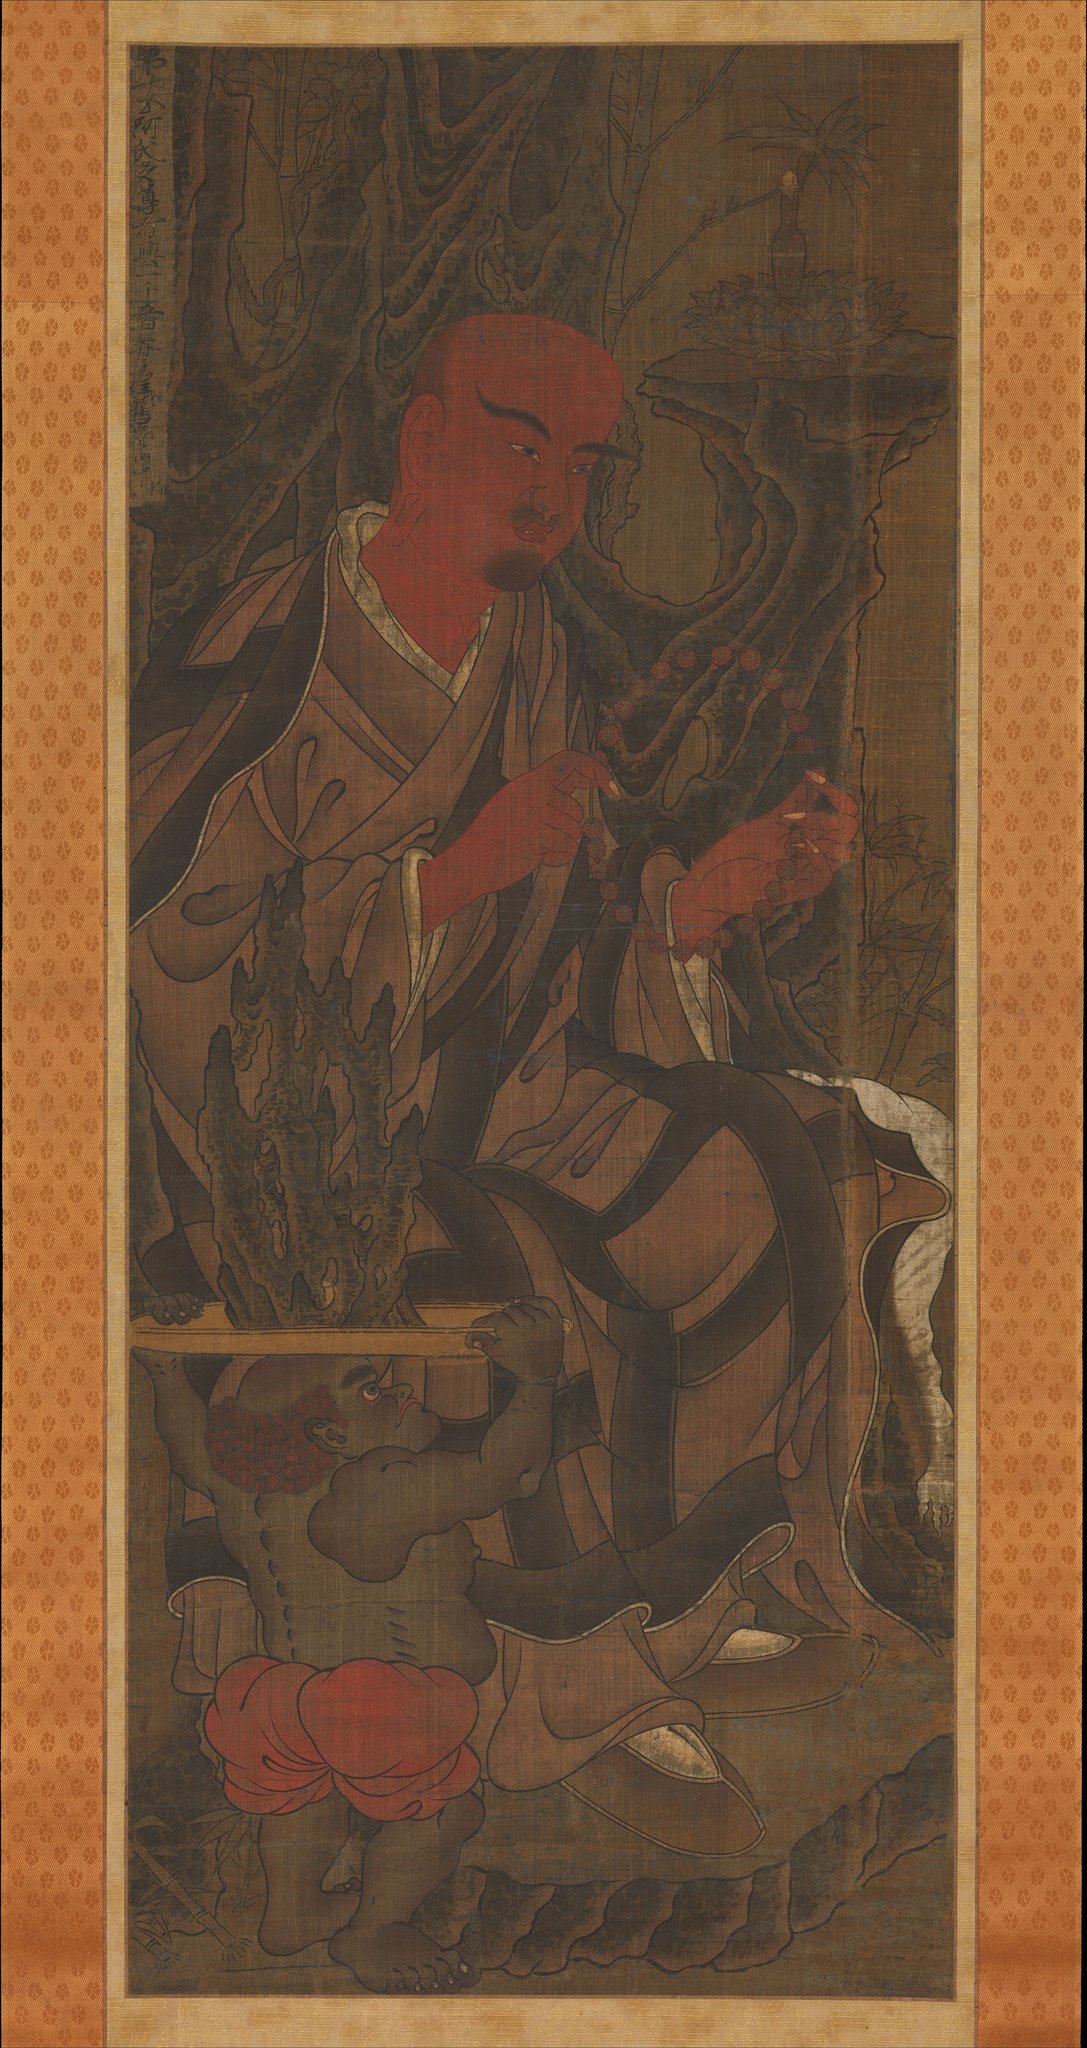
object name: hanging scroll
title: Arhats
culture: japanese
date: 1367-1400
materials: ink, silk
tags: men,buddhism